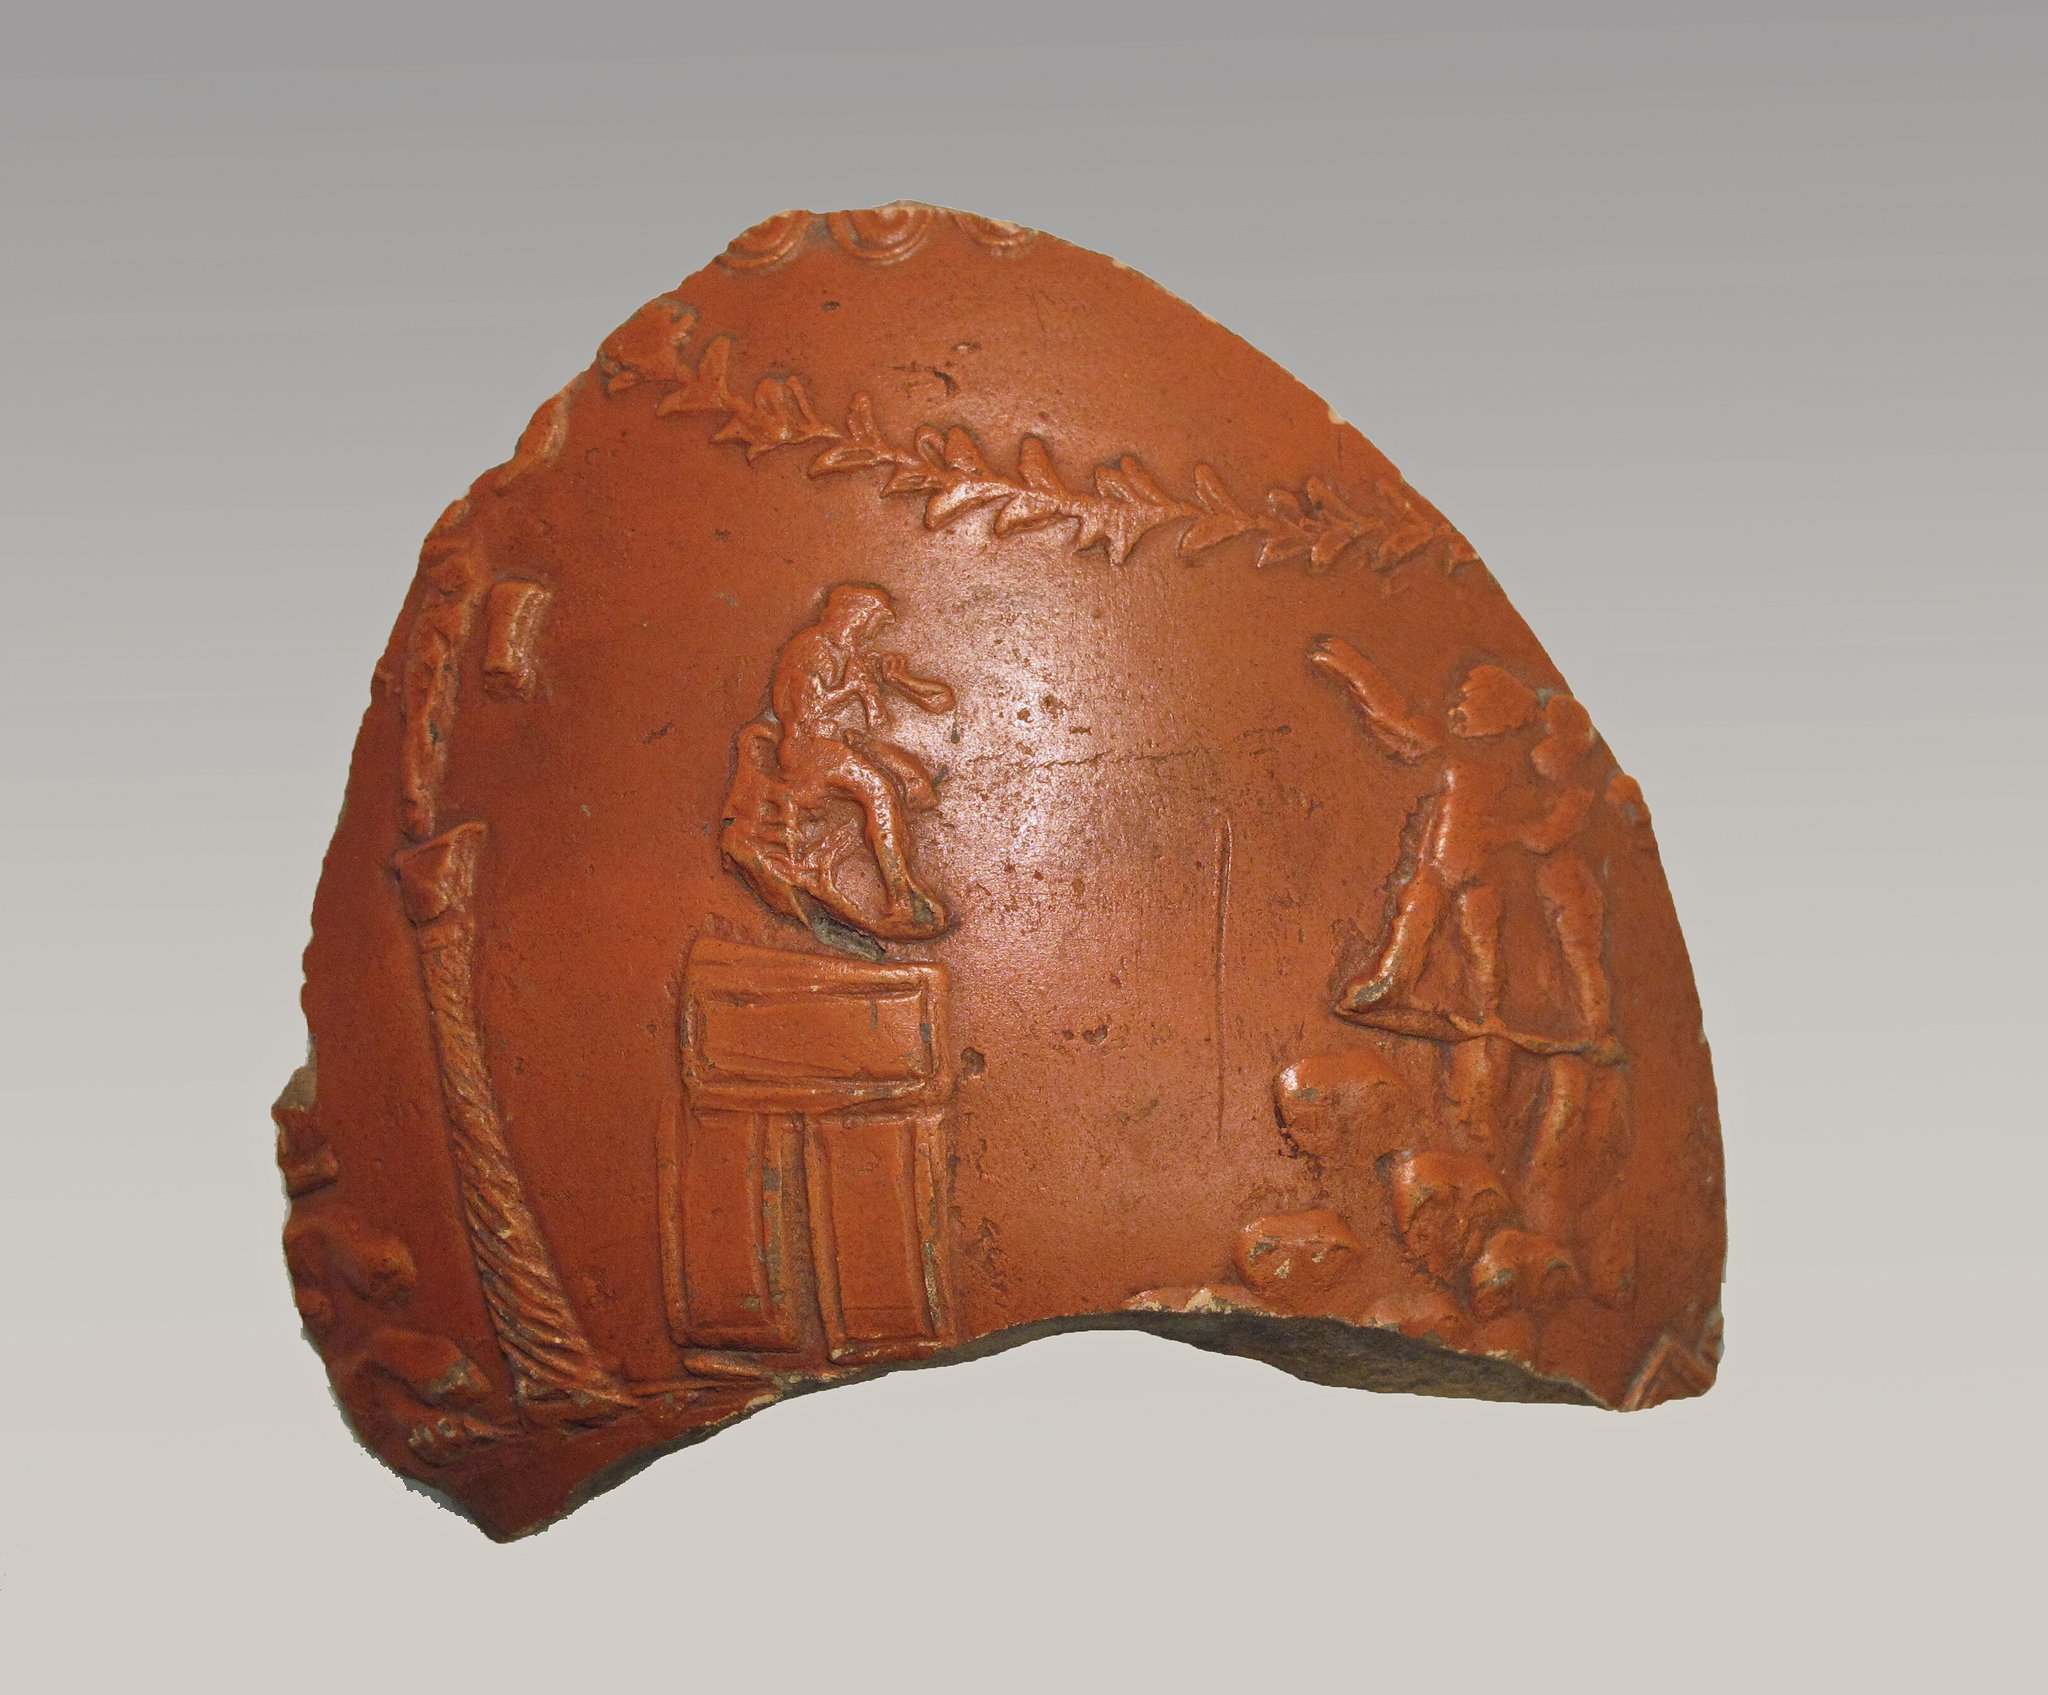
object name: vase fragment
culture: roman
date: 100 BCE-100 CE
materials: terracotta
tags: musicians